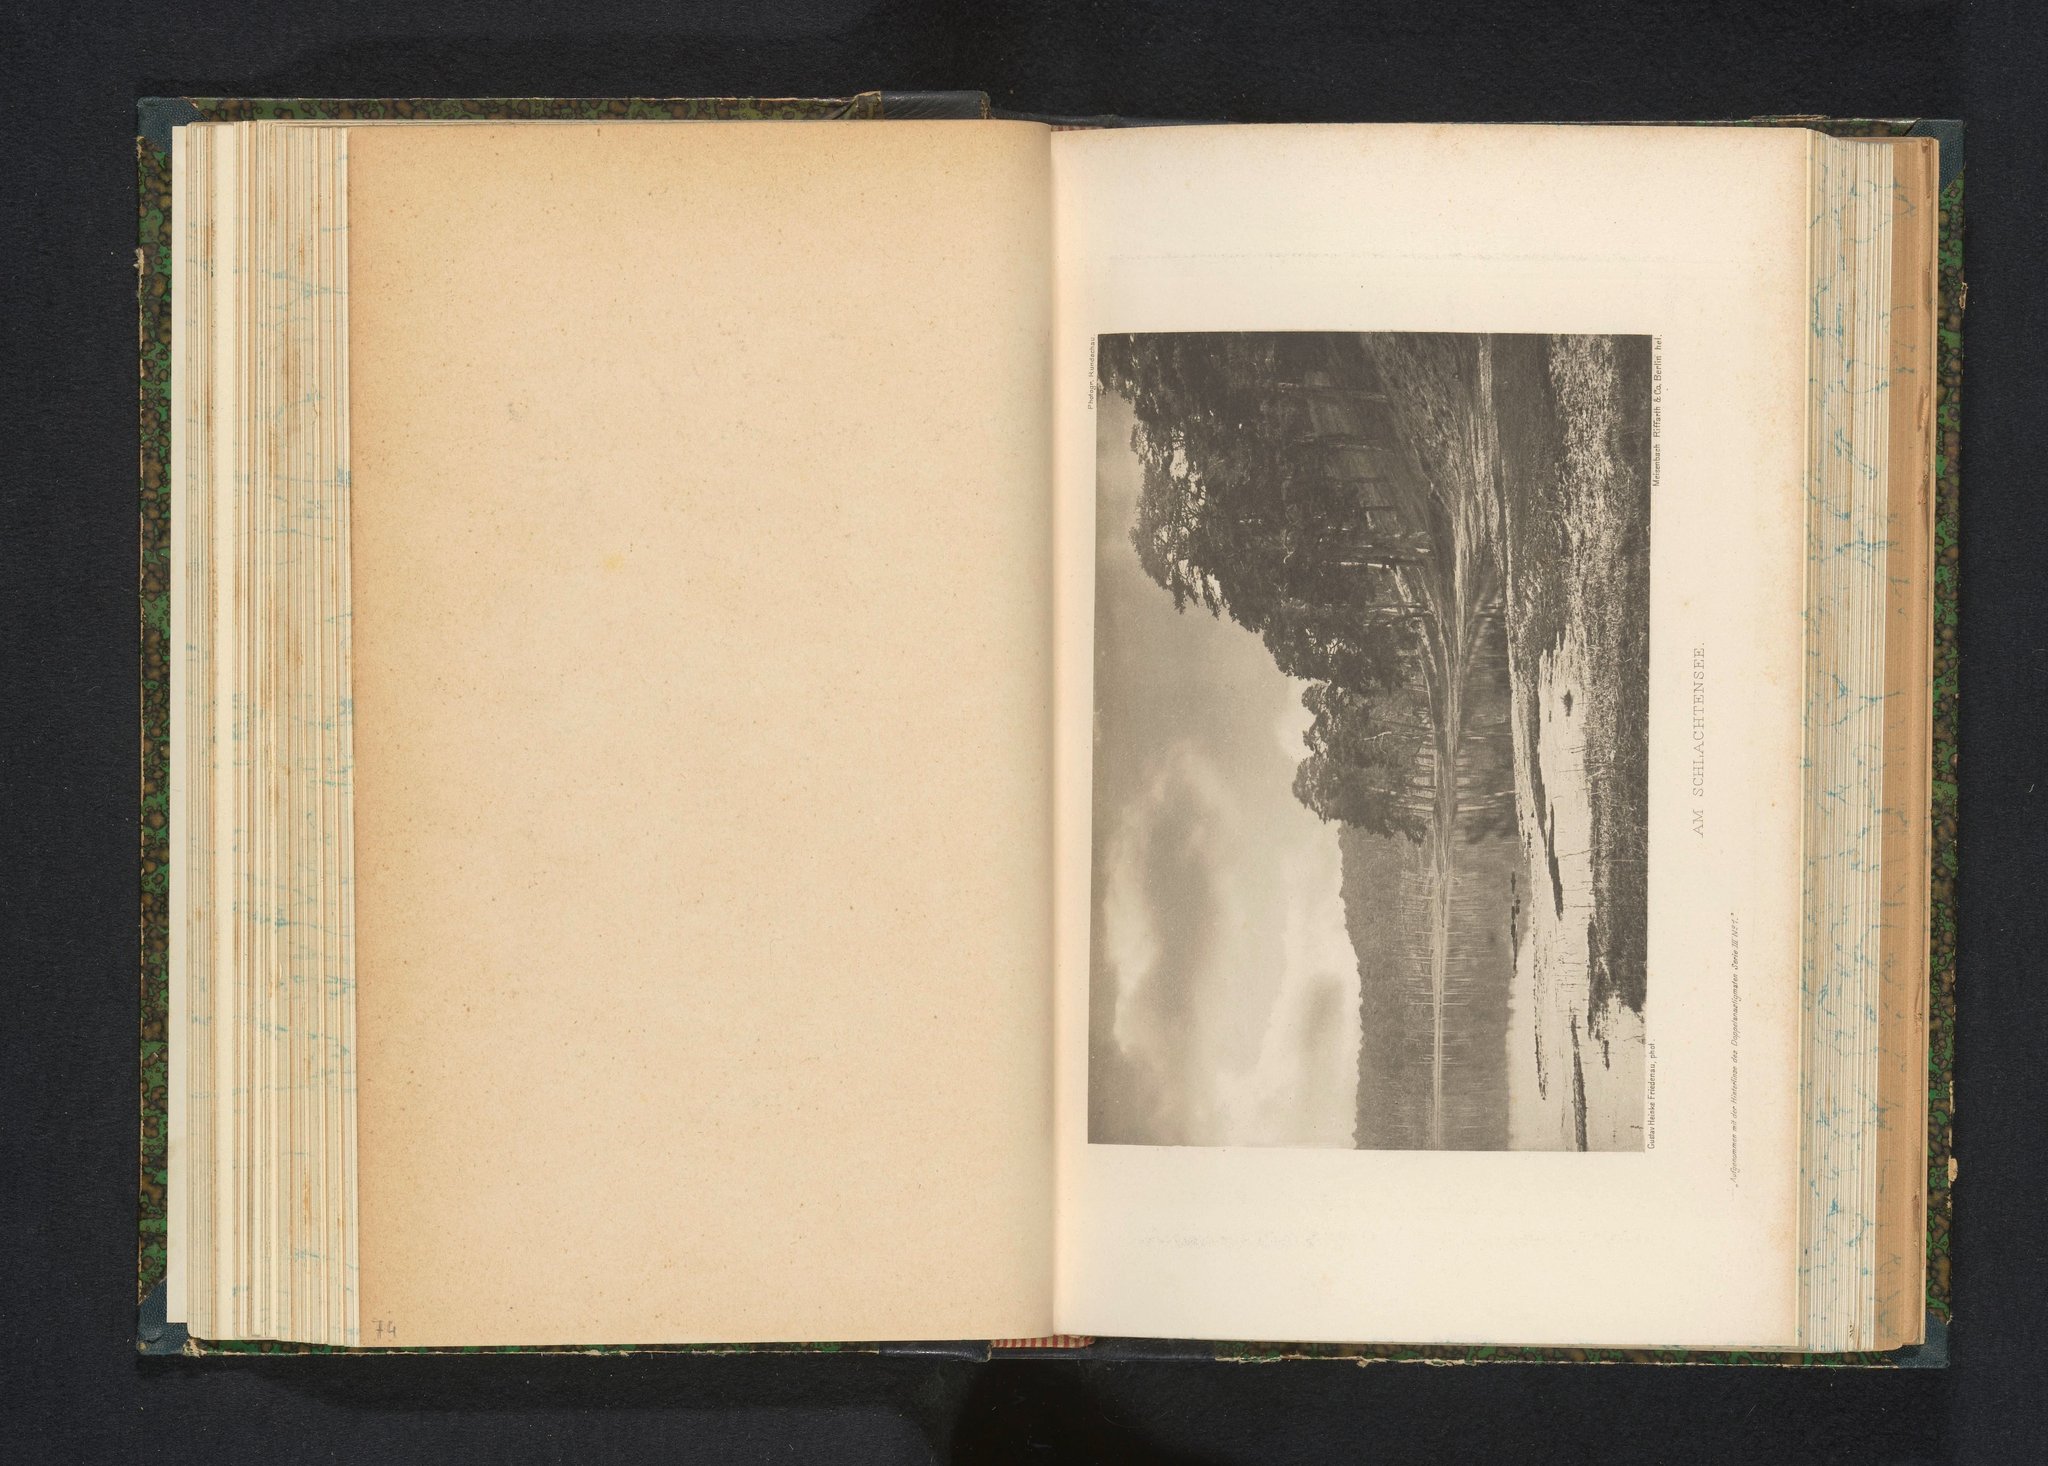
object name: photomechanical print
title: Gezicht op de Slachtensee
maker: gustav heinke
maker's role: fotograaf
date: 1894-1899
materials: paper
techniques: photoaquatint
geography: berlin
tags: lake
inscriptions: inscription: ‘"Aufgenommen mit der Hinterlinse des Doppelanastigmaten Serie III No. 1."’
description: Prent op tweede ongenummerde pagina na pagina 128.